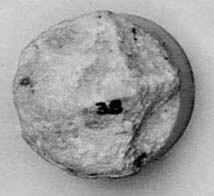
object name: fragment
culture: burmese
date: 1902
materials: jade